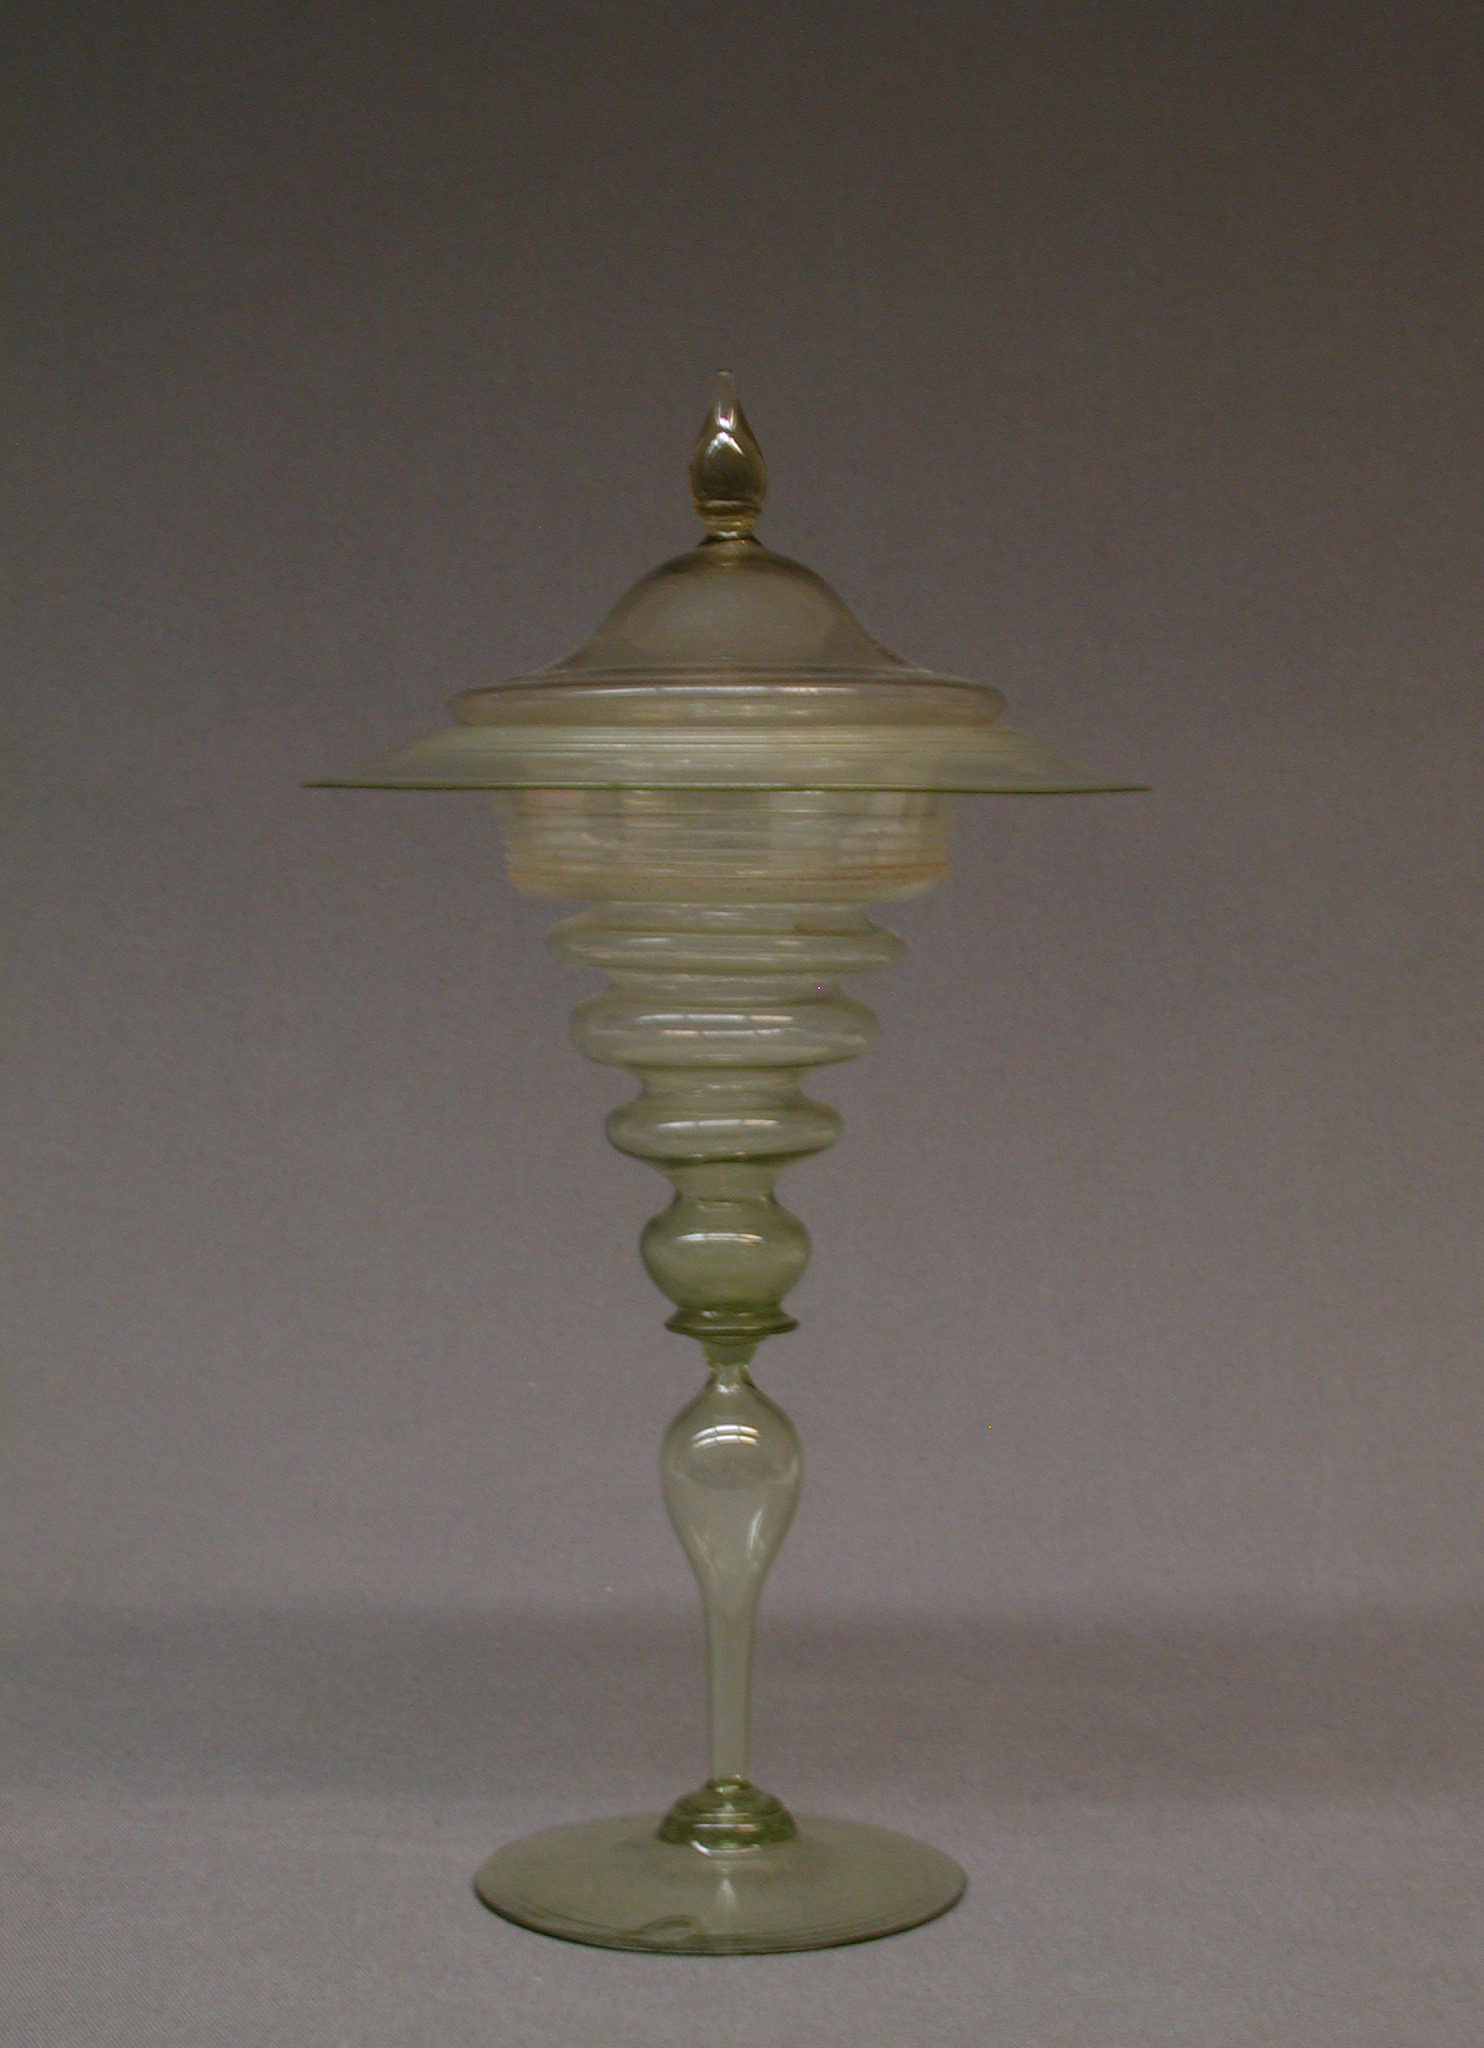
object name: standing cup with cover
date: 1801-1900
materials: glass